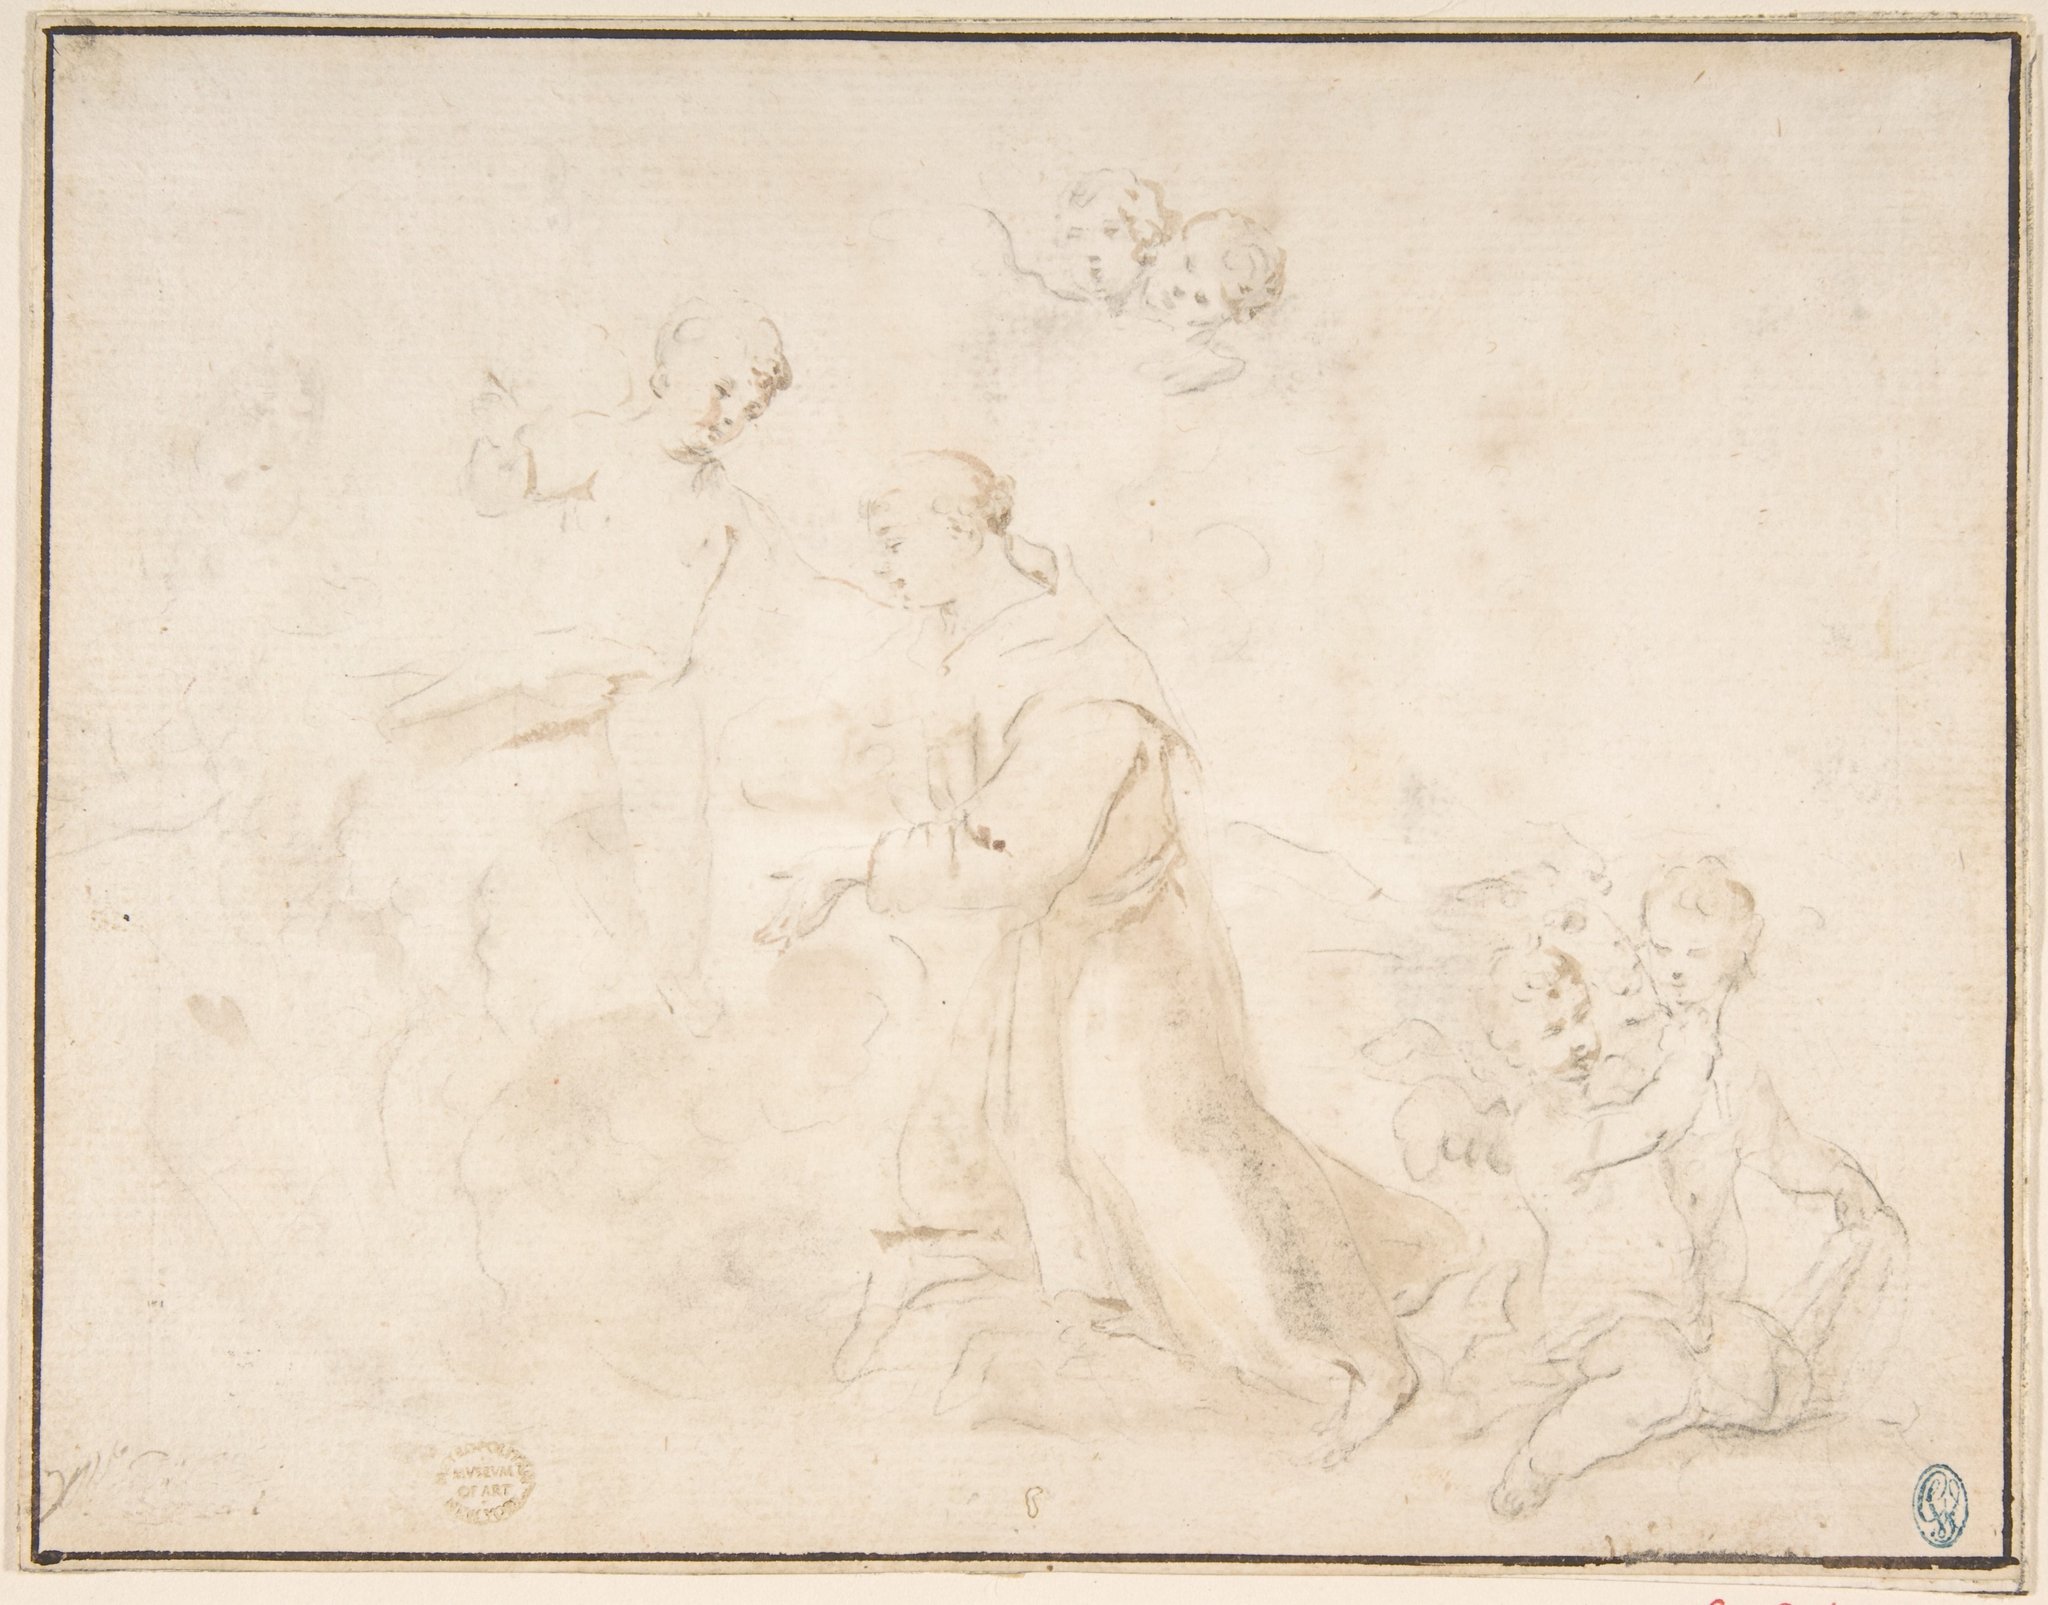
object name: drawing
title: Saint Anthony of Padua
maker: anonymous, spanish, 17th century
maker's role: artist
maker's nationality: spanish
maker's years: 1600-1700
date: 1601-1700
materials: chalk, ink, paper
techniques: brush, pen, wash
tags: angels,saint anthony